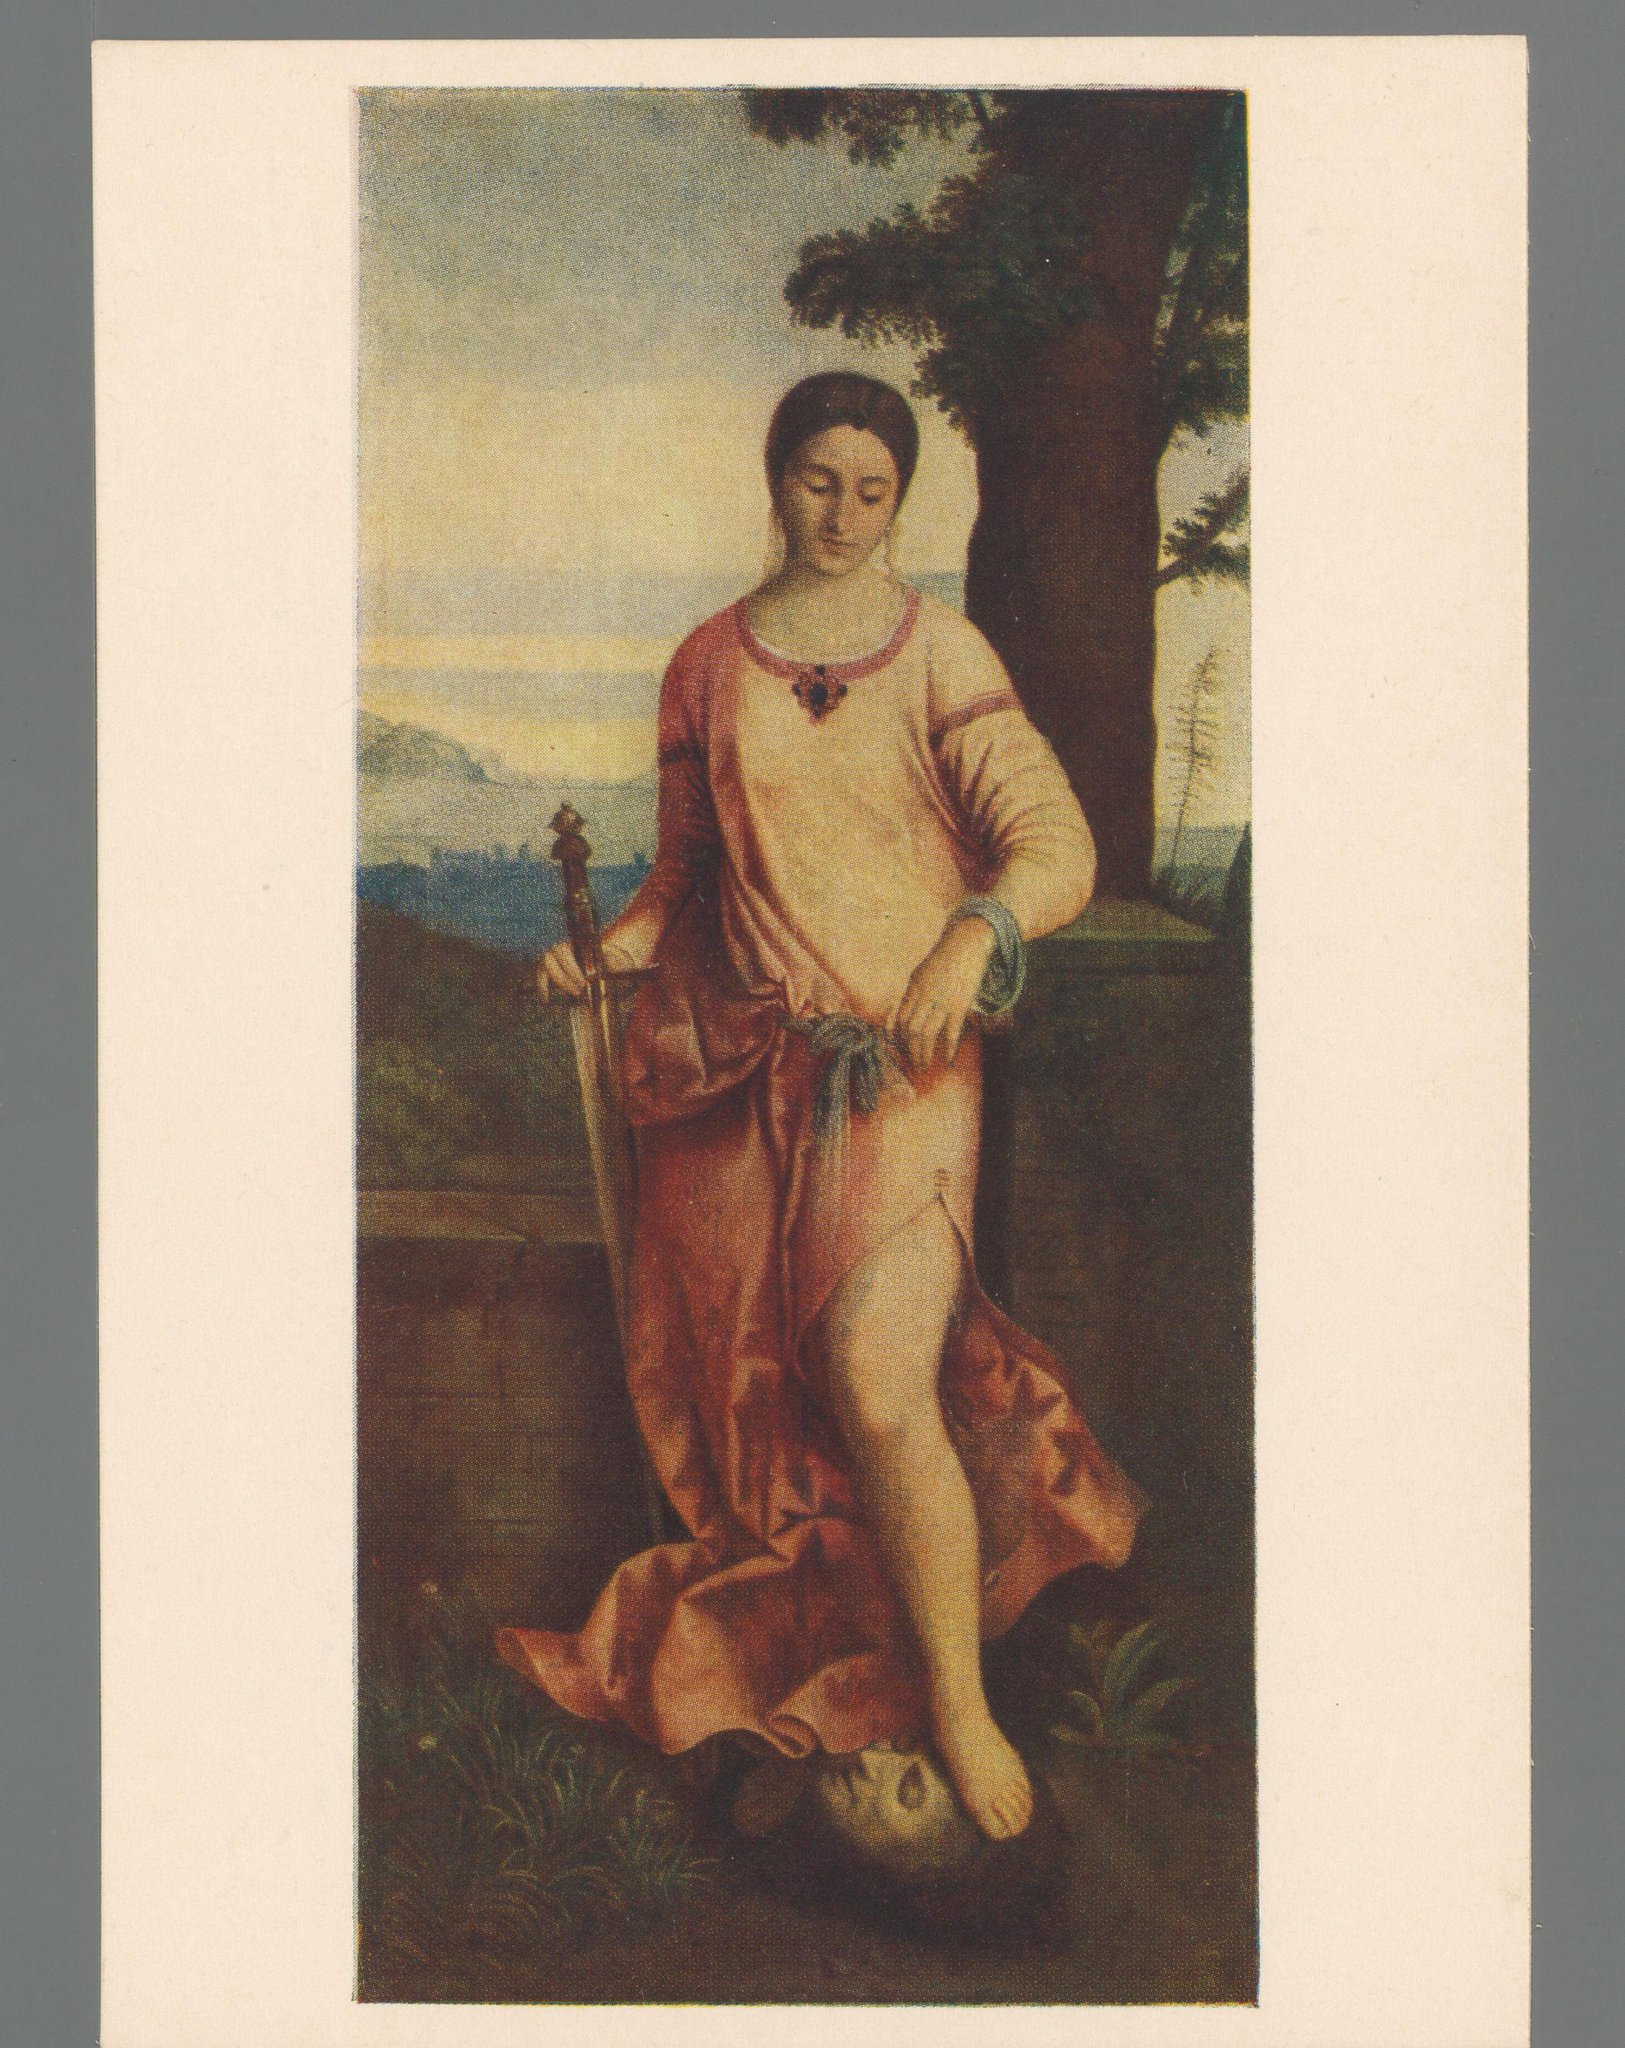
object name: reproduction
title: Giorgione. Judith / Giorgione da Castelfranco. Judith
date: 1956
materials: cardboard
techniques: color autotype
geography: moscow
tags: permanent exhibition, museum, picture, painting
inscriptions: date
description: De titel op object staat ook in het Russisch.